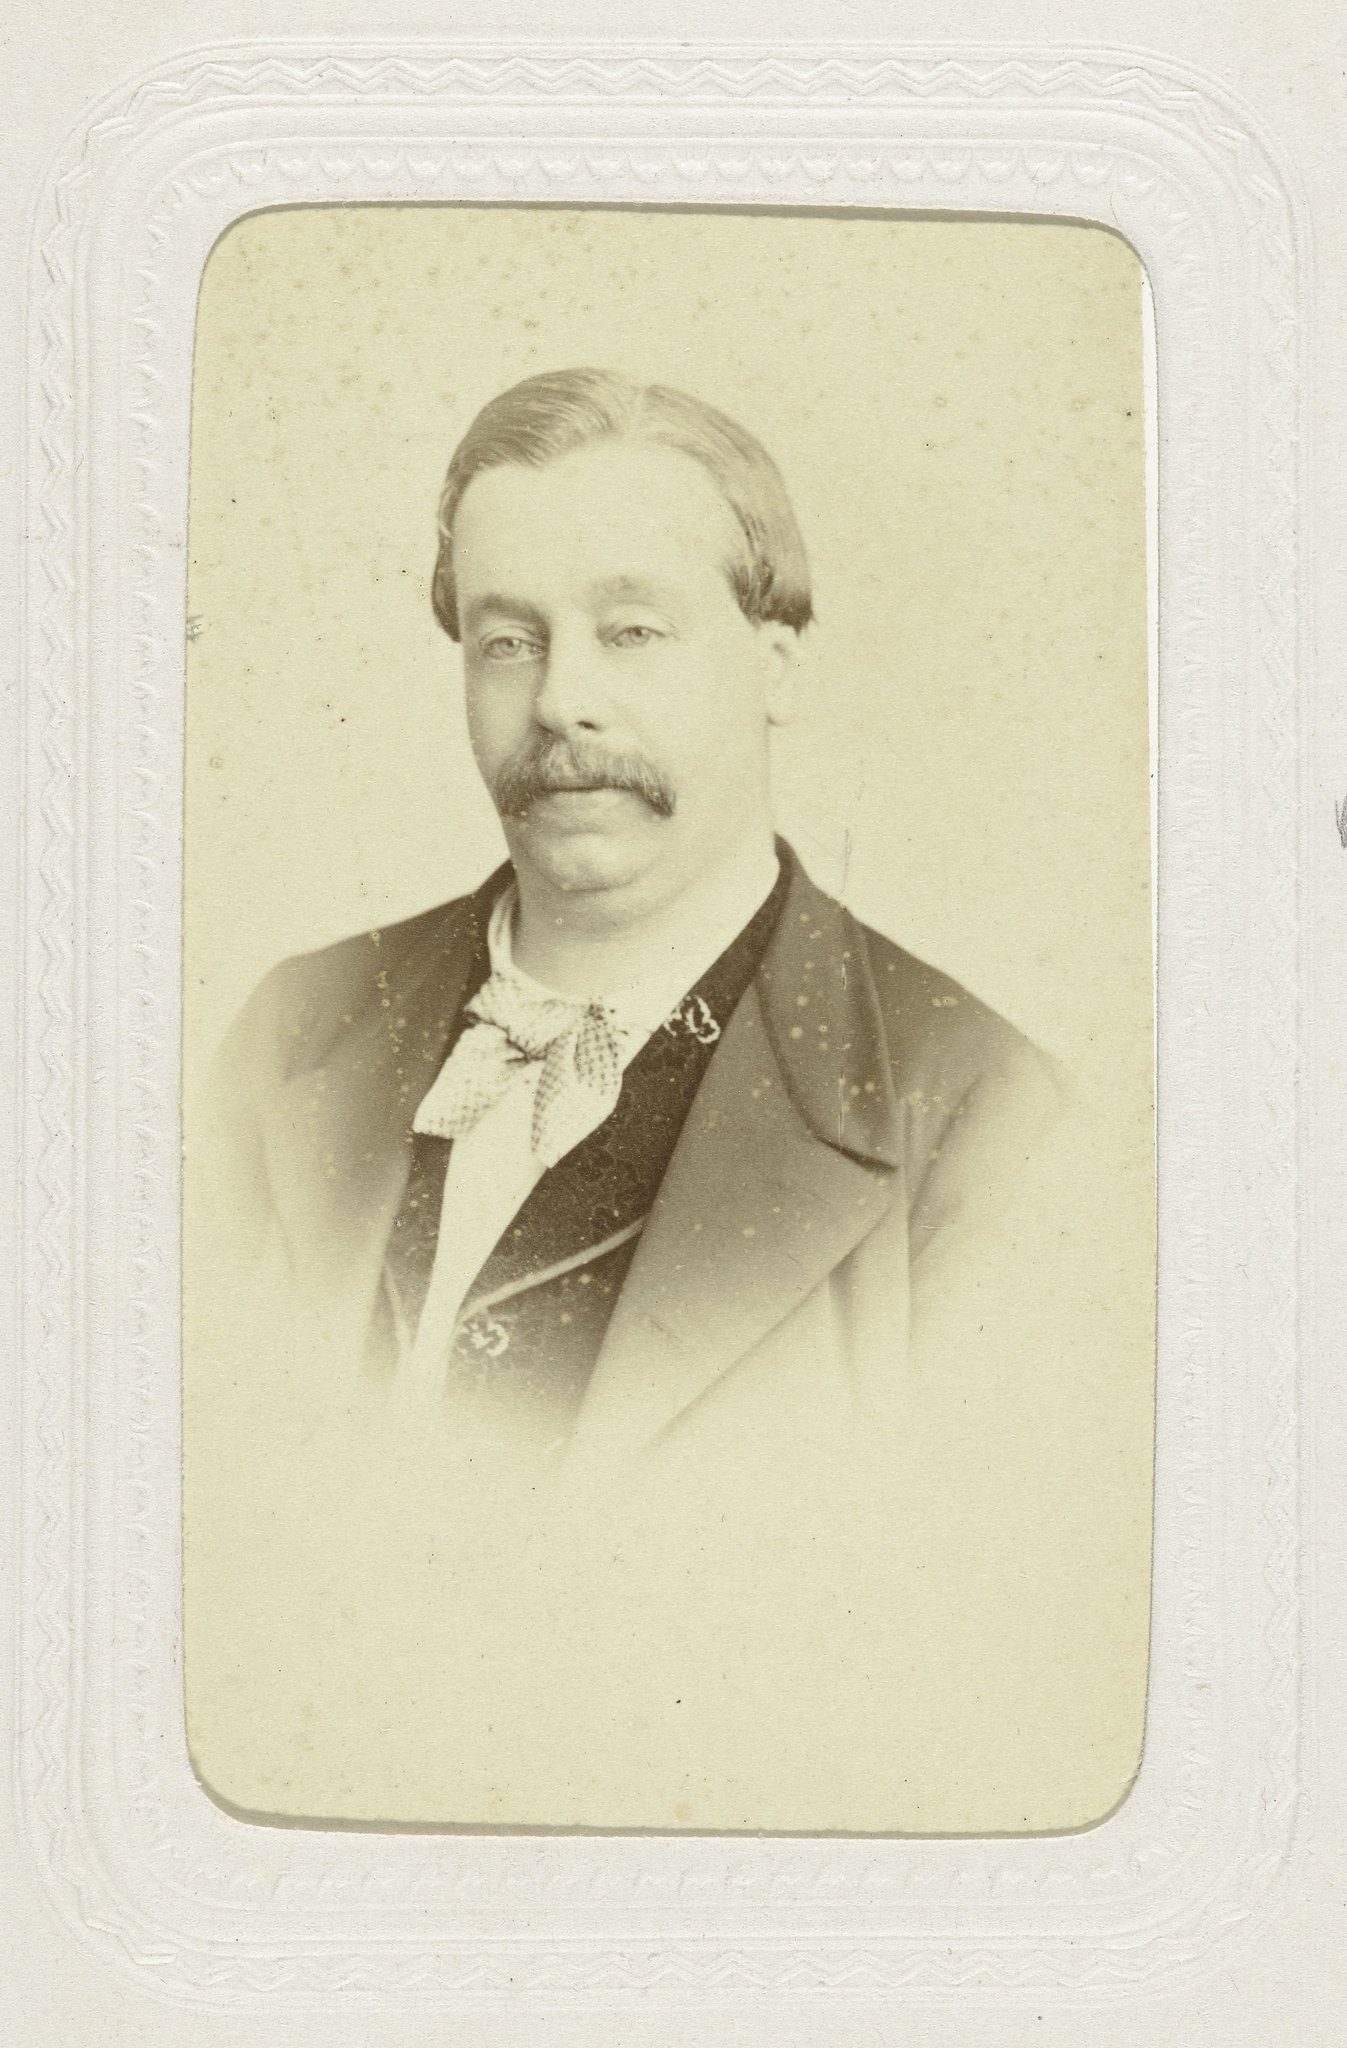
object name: carte de visite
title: Studioportret van een gezette man met snor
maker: charles reutlinger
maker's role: publisher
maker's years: 1816-1880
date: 1863-1870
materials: cardboard, paper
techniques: albumen print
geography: paris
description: De man draagt een pak met daaronder een strikje